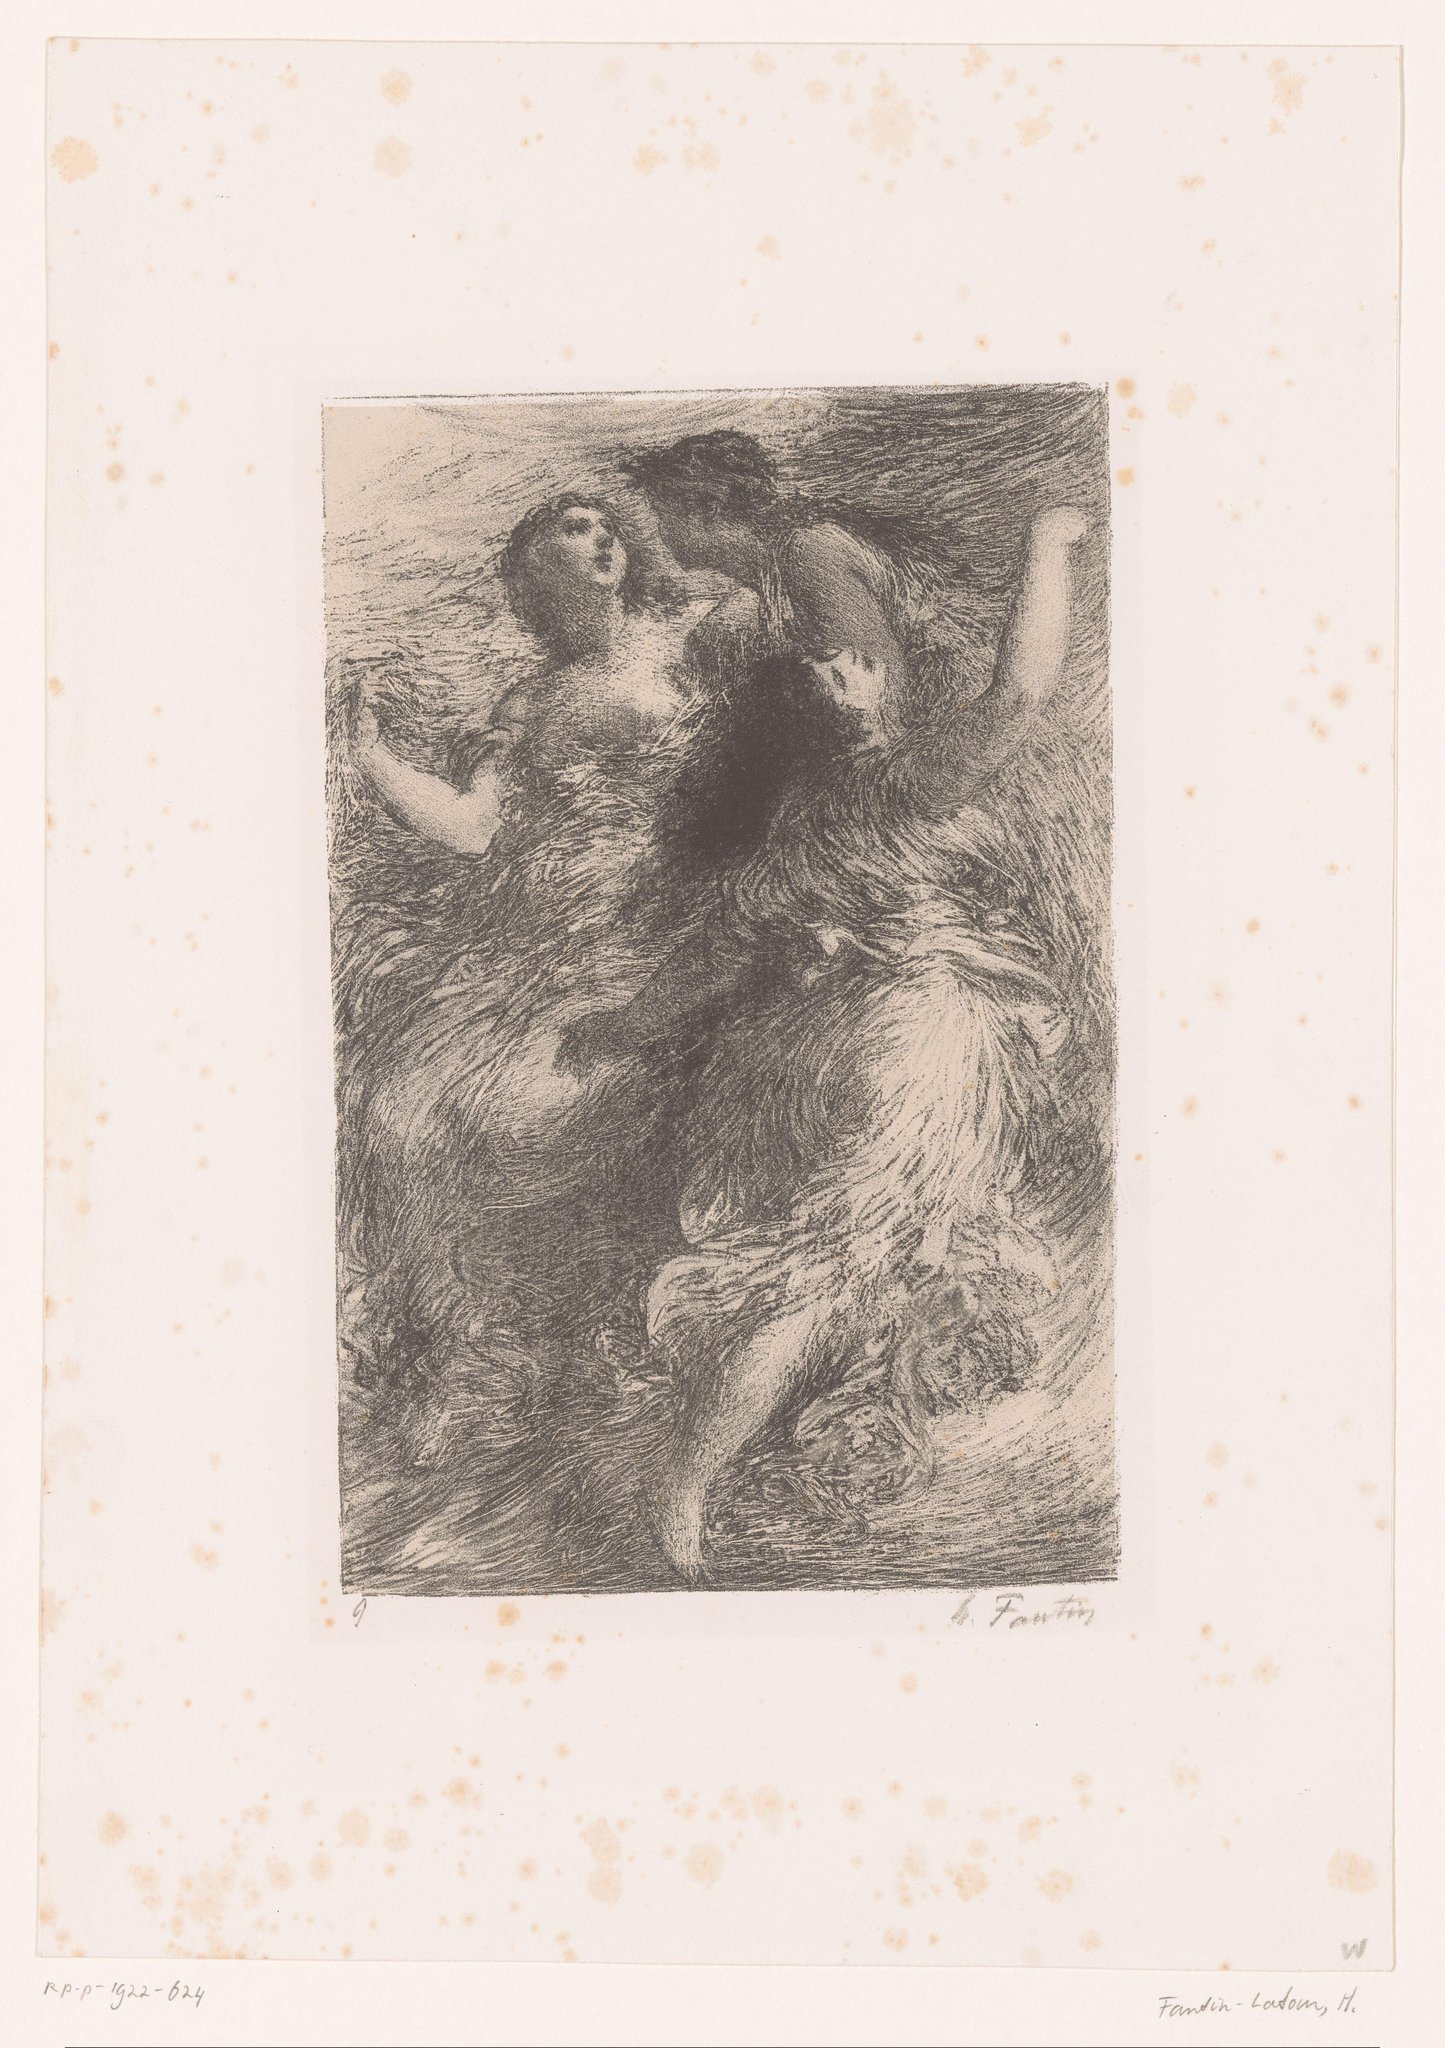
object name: book illustration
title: L’Or du Rhin. Scène I. Les Filles du Rhin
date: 1886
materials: paper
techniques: lithography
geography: paris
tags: 'nibelungenlied', opera, naiads, river- and spring-nymphs; usually carrying an urn; 'naiadi, ninfe de' fiumi' (ripa)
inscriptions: collector's mark: Lugt 2228a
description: Prent gebruikt voor: Jullien, A. Richard Wagner: sa vie et ses œuvres. Parijs: Gauchez 1886. Prent ook gebruikt voor: Le Monde illustré, 21 augustus 1886. Scène uit Wagners opera Das Rheingold (eerste bedrijf).